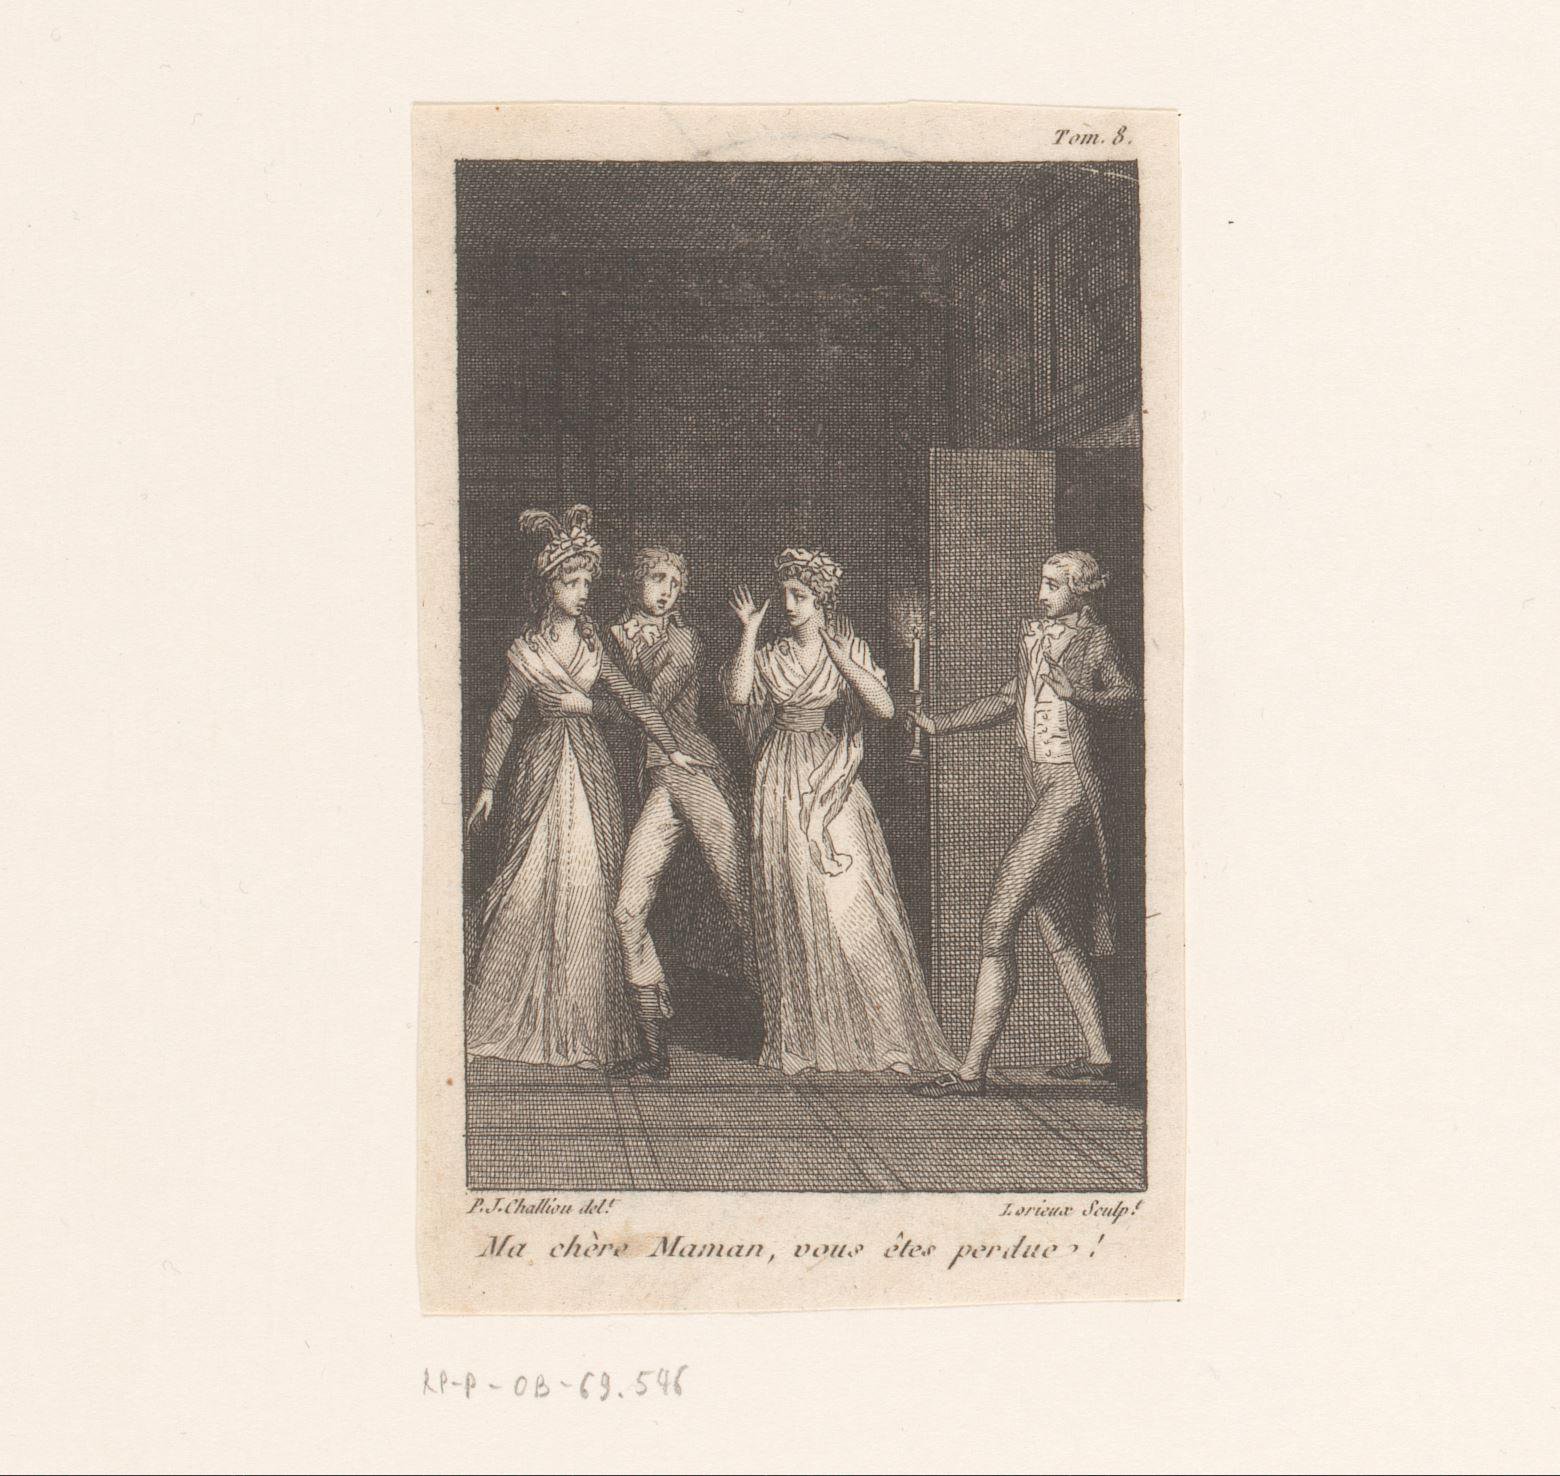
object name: book illustration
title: Twee mannen en twee vrouwen in een interieur met een openstaande deur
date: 1791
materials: paper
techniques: etching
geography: france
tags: adult woman, adult man, opening the door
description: Mogelijk prent uit: Louvet de Couvray, Jean-Baptiste. Les amours et les galanteries du chevalier De Faublas. Parijs: M. Louvet de Couvray, 1791, dl. 8, of een later geïllustreerde editie.